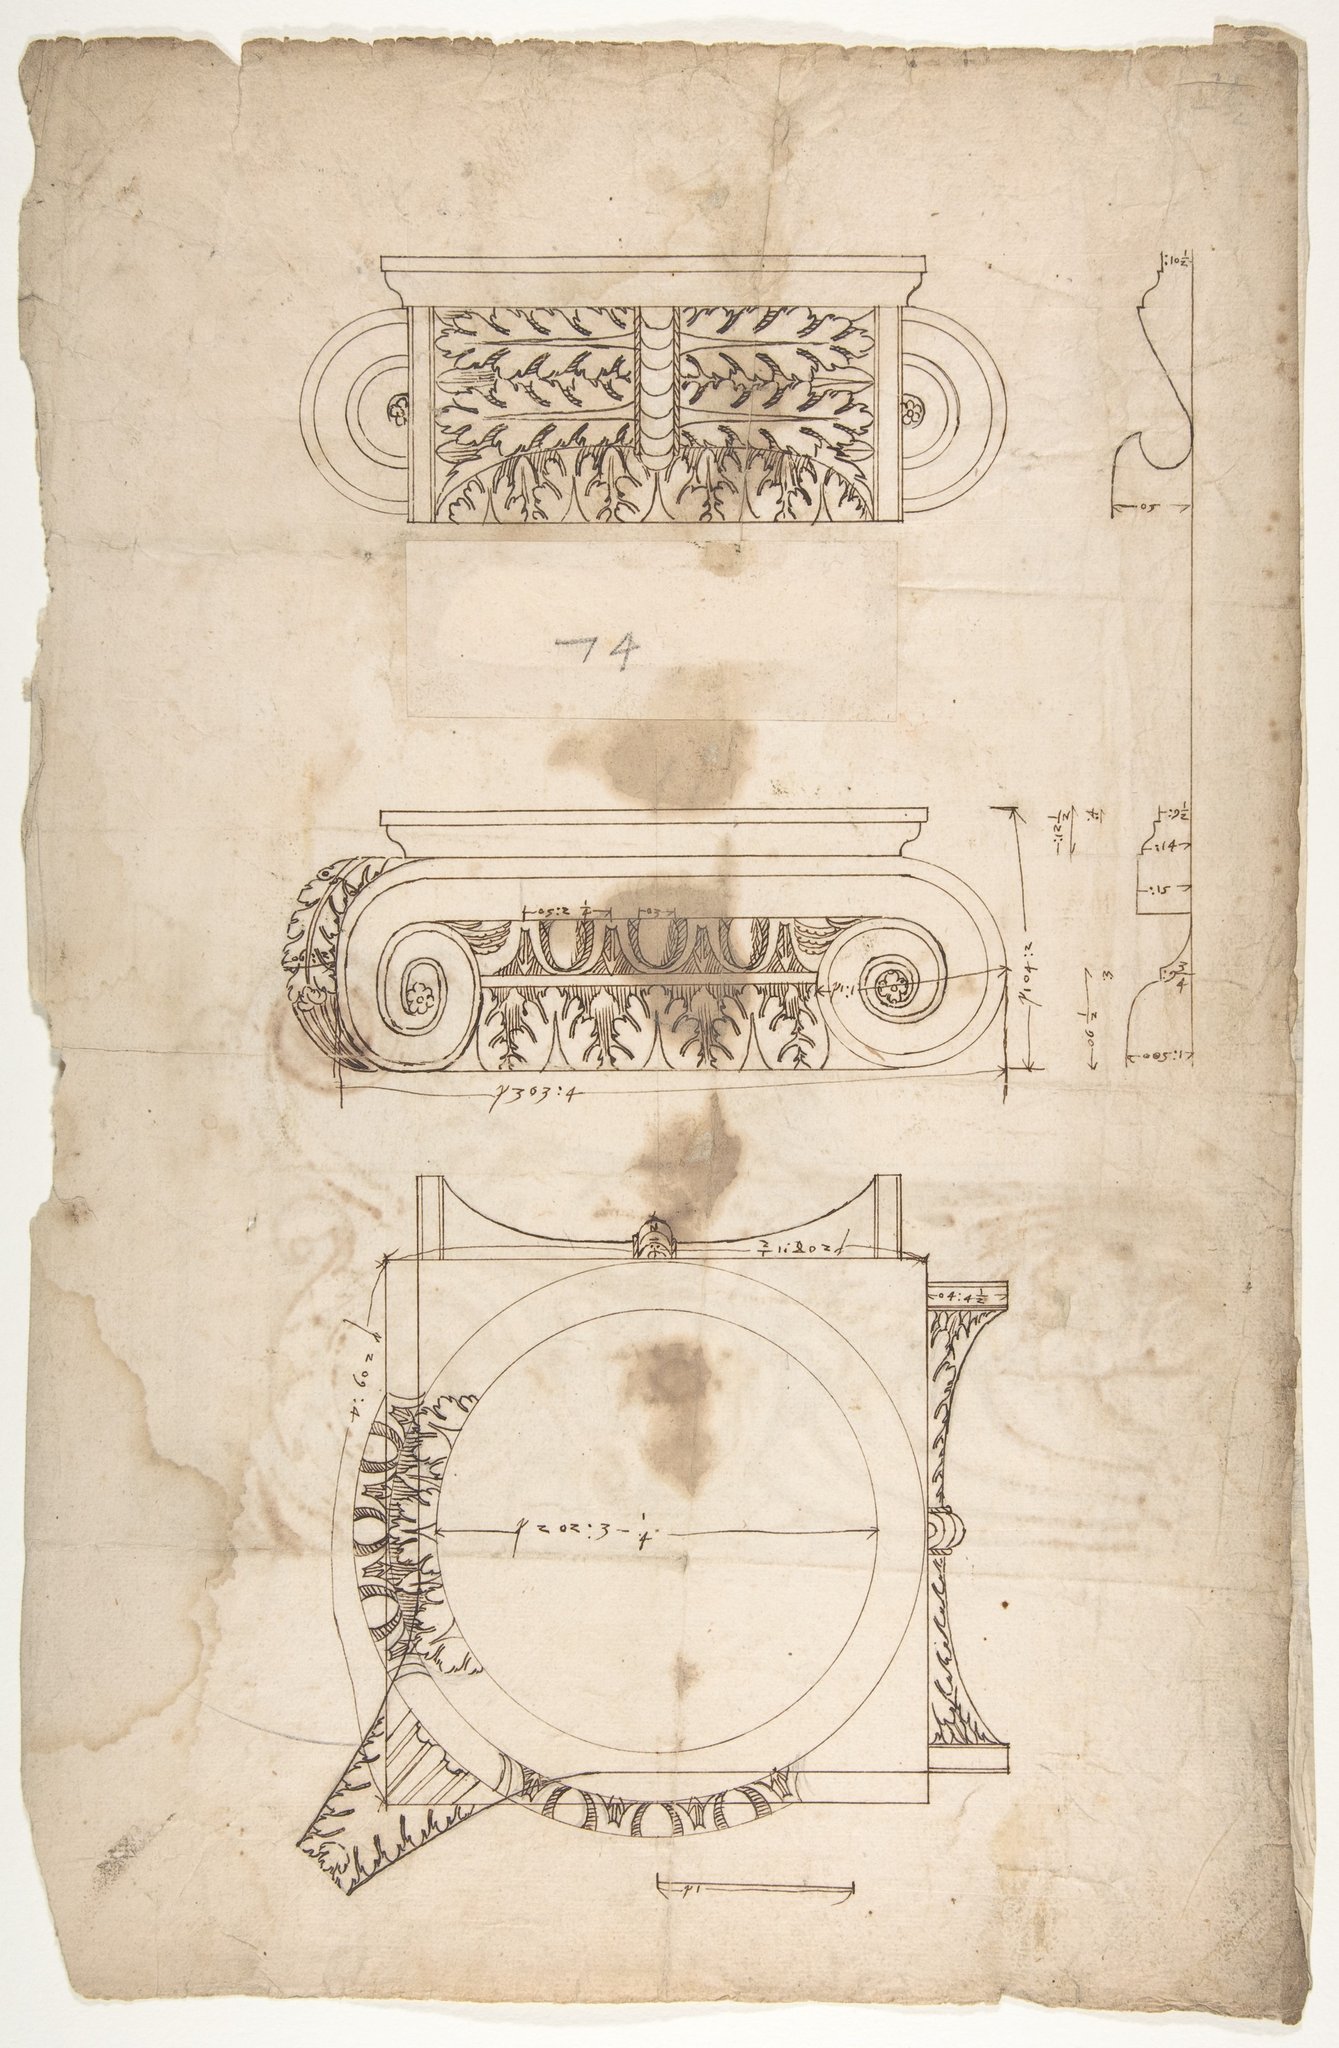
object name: collection ornament architecture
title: Temple of Portonus, capital, elevations and plan (recto) Unidentified, capital, elevation (verso)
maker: anonymous, french, 16th century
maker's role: draftsman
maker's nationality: french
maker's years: 1500-1600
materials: chalk, ink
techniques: incising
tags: capitals